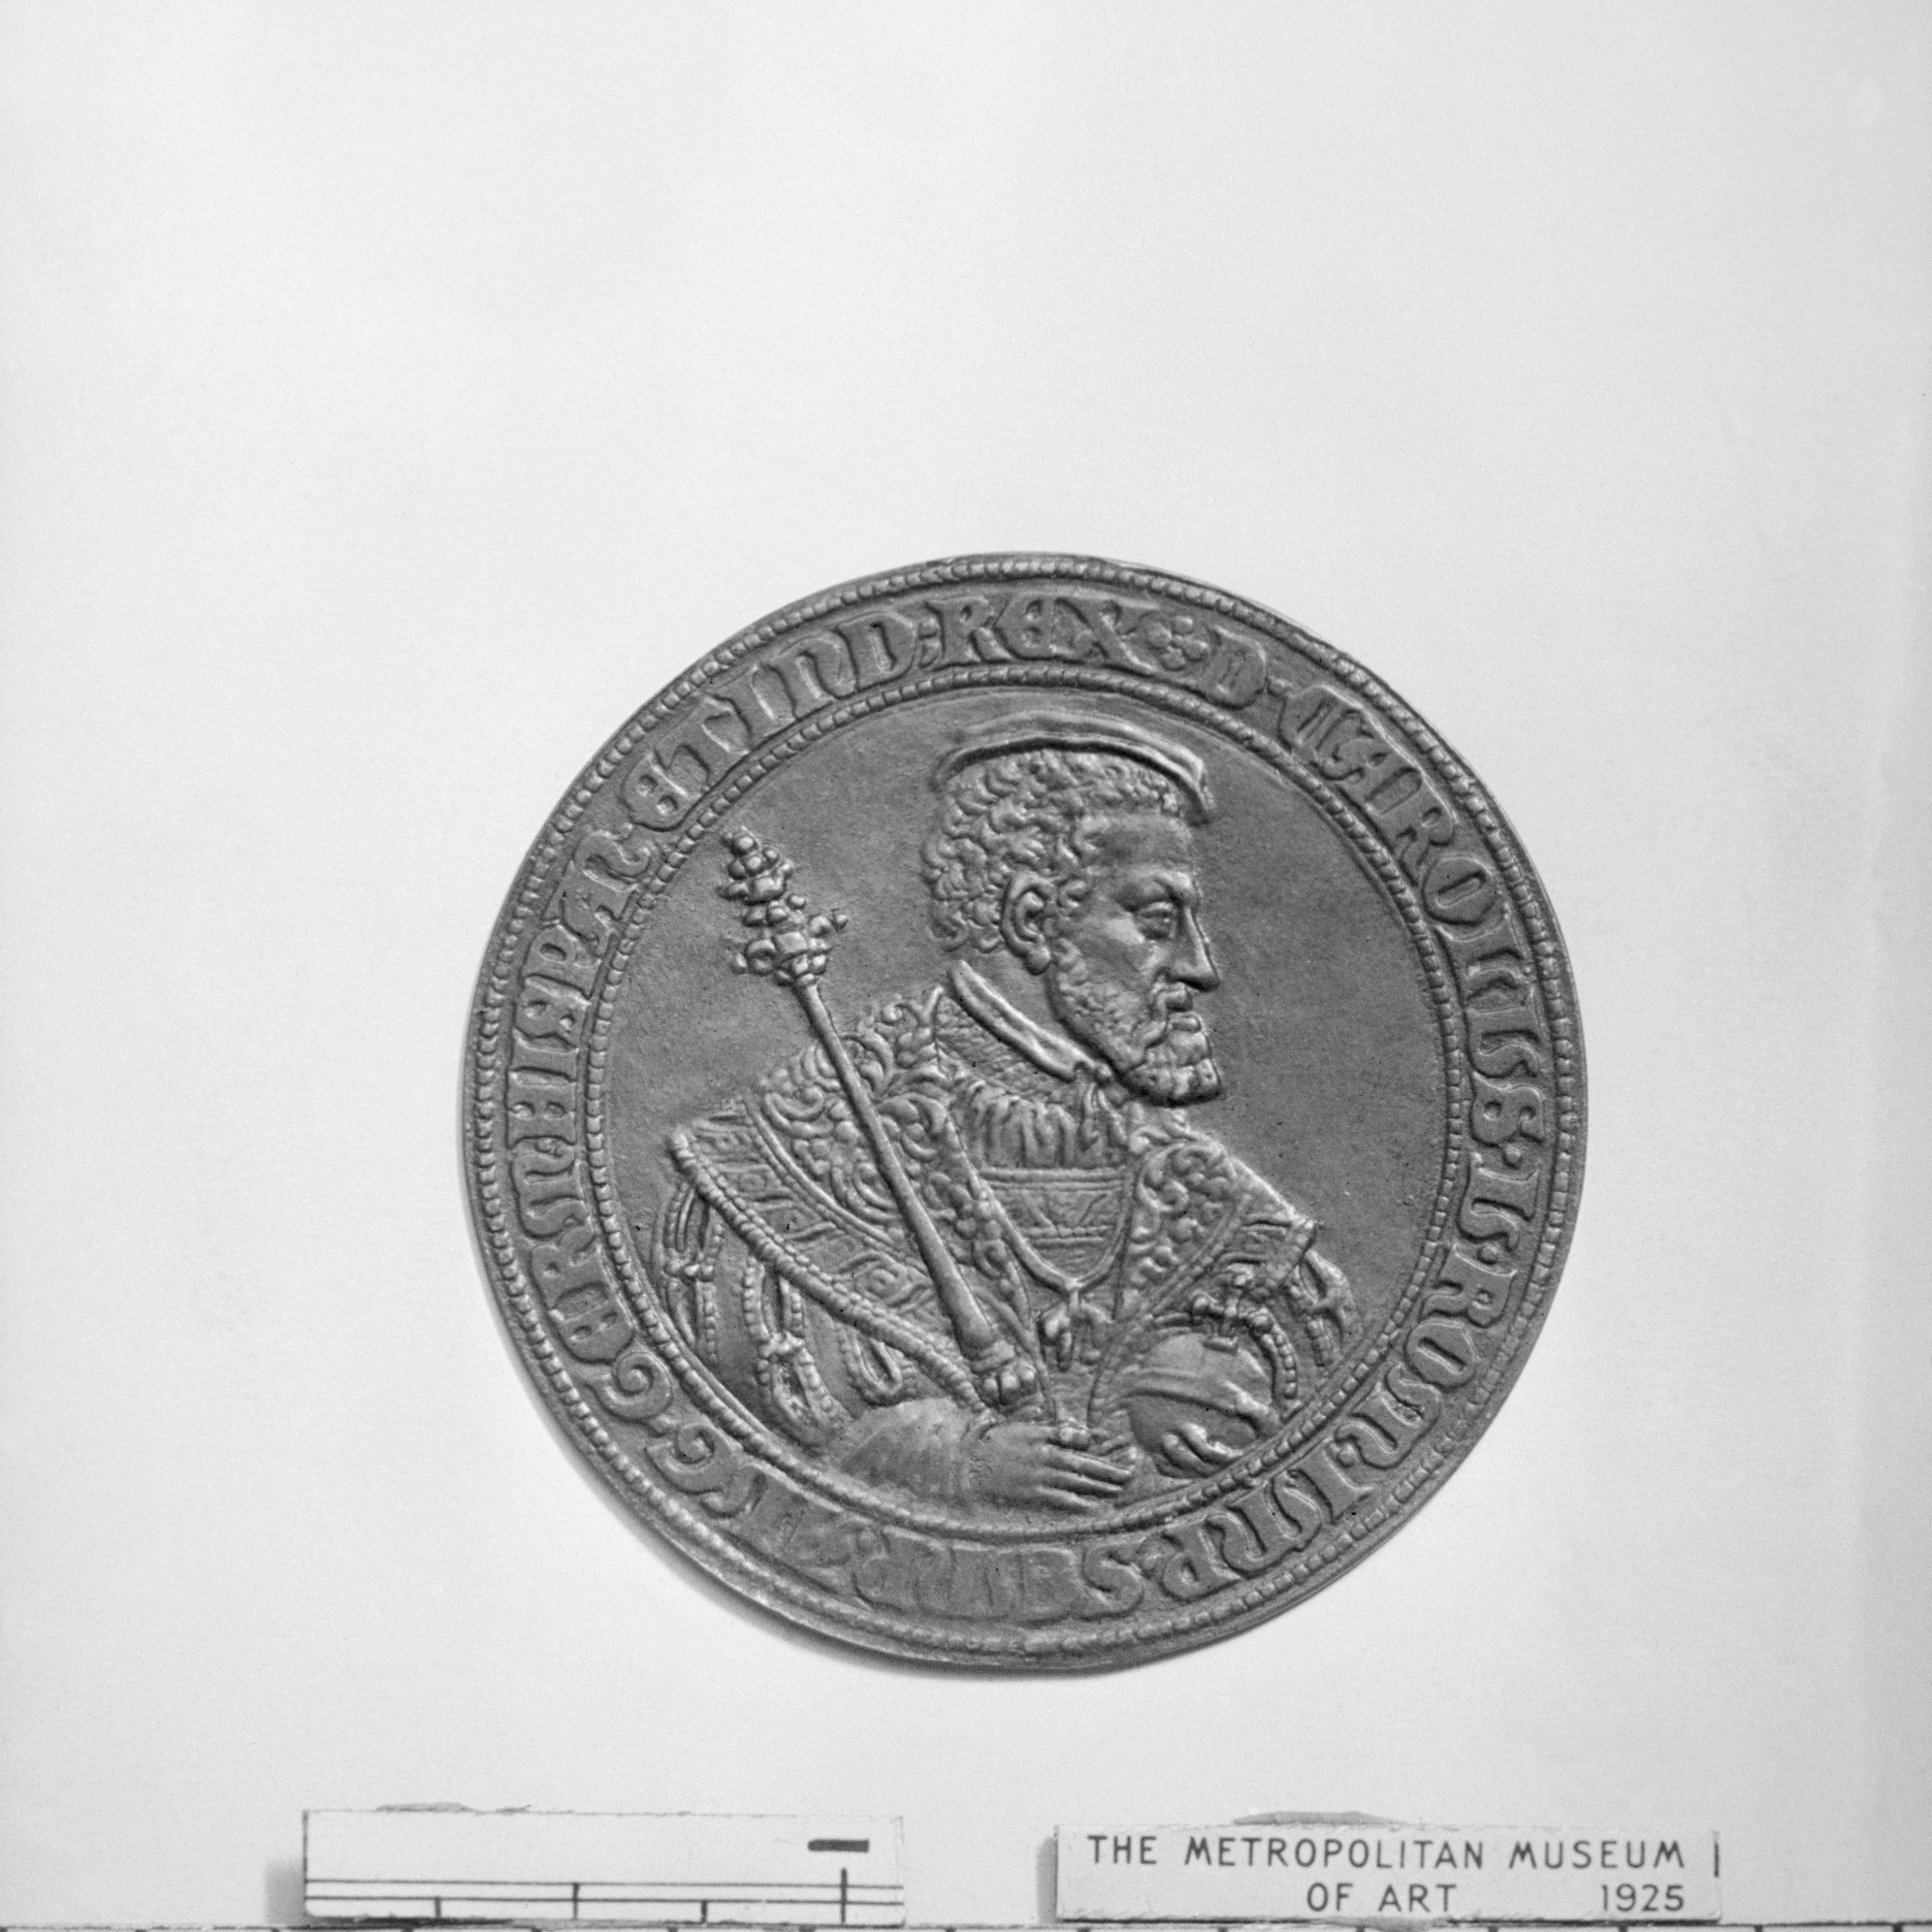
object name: medal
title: Emperor Charles V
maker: koehler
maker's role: artist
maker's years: 1700-1800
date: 1701-1800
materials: bronze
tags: birds,men,profiles